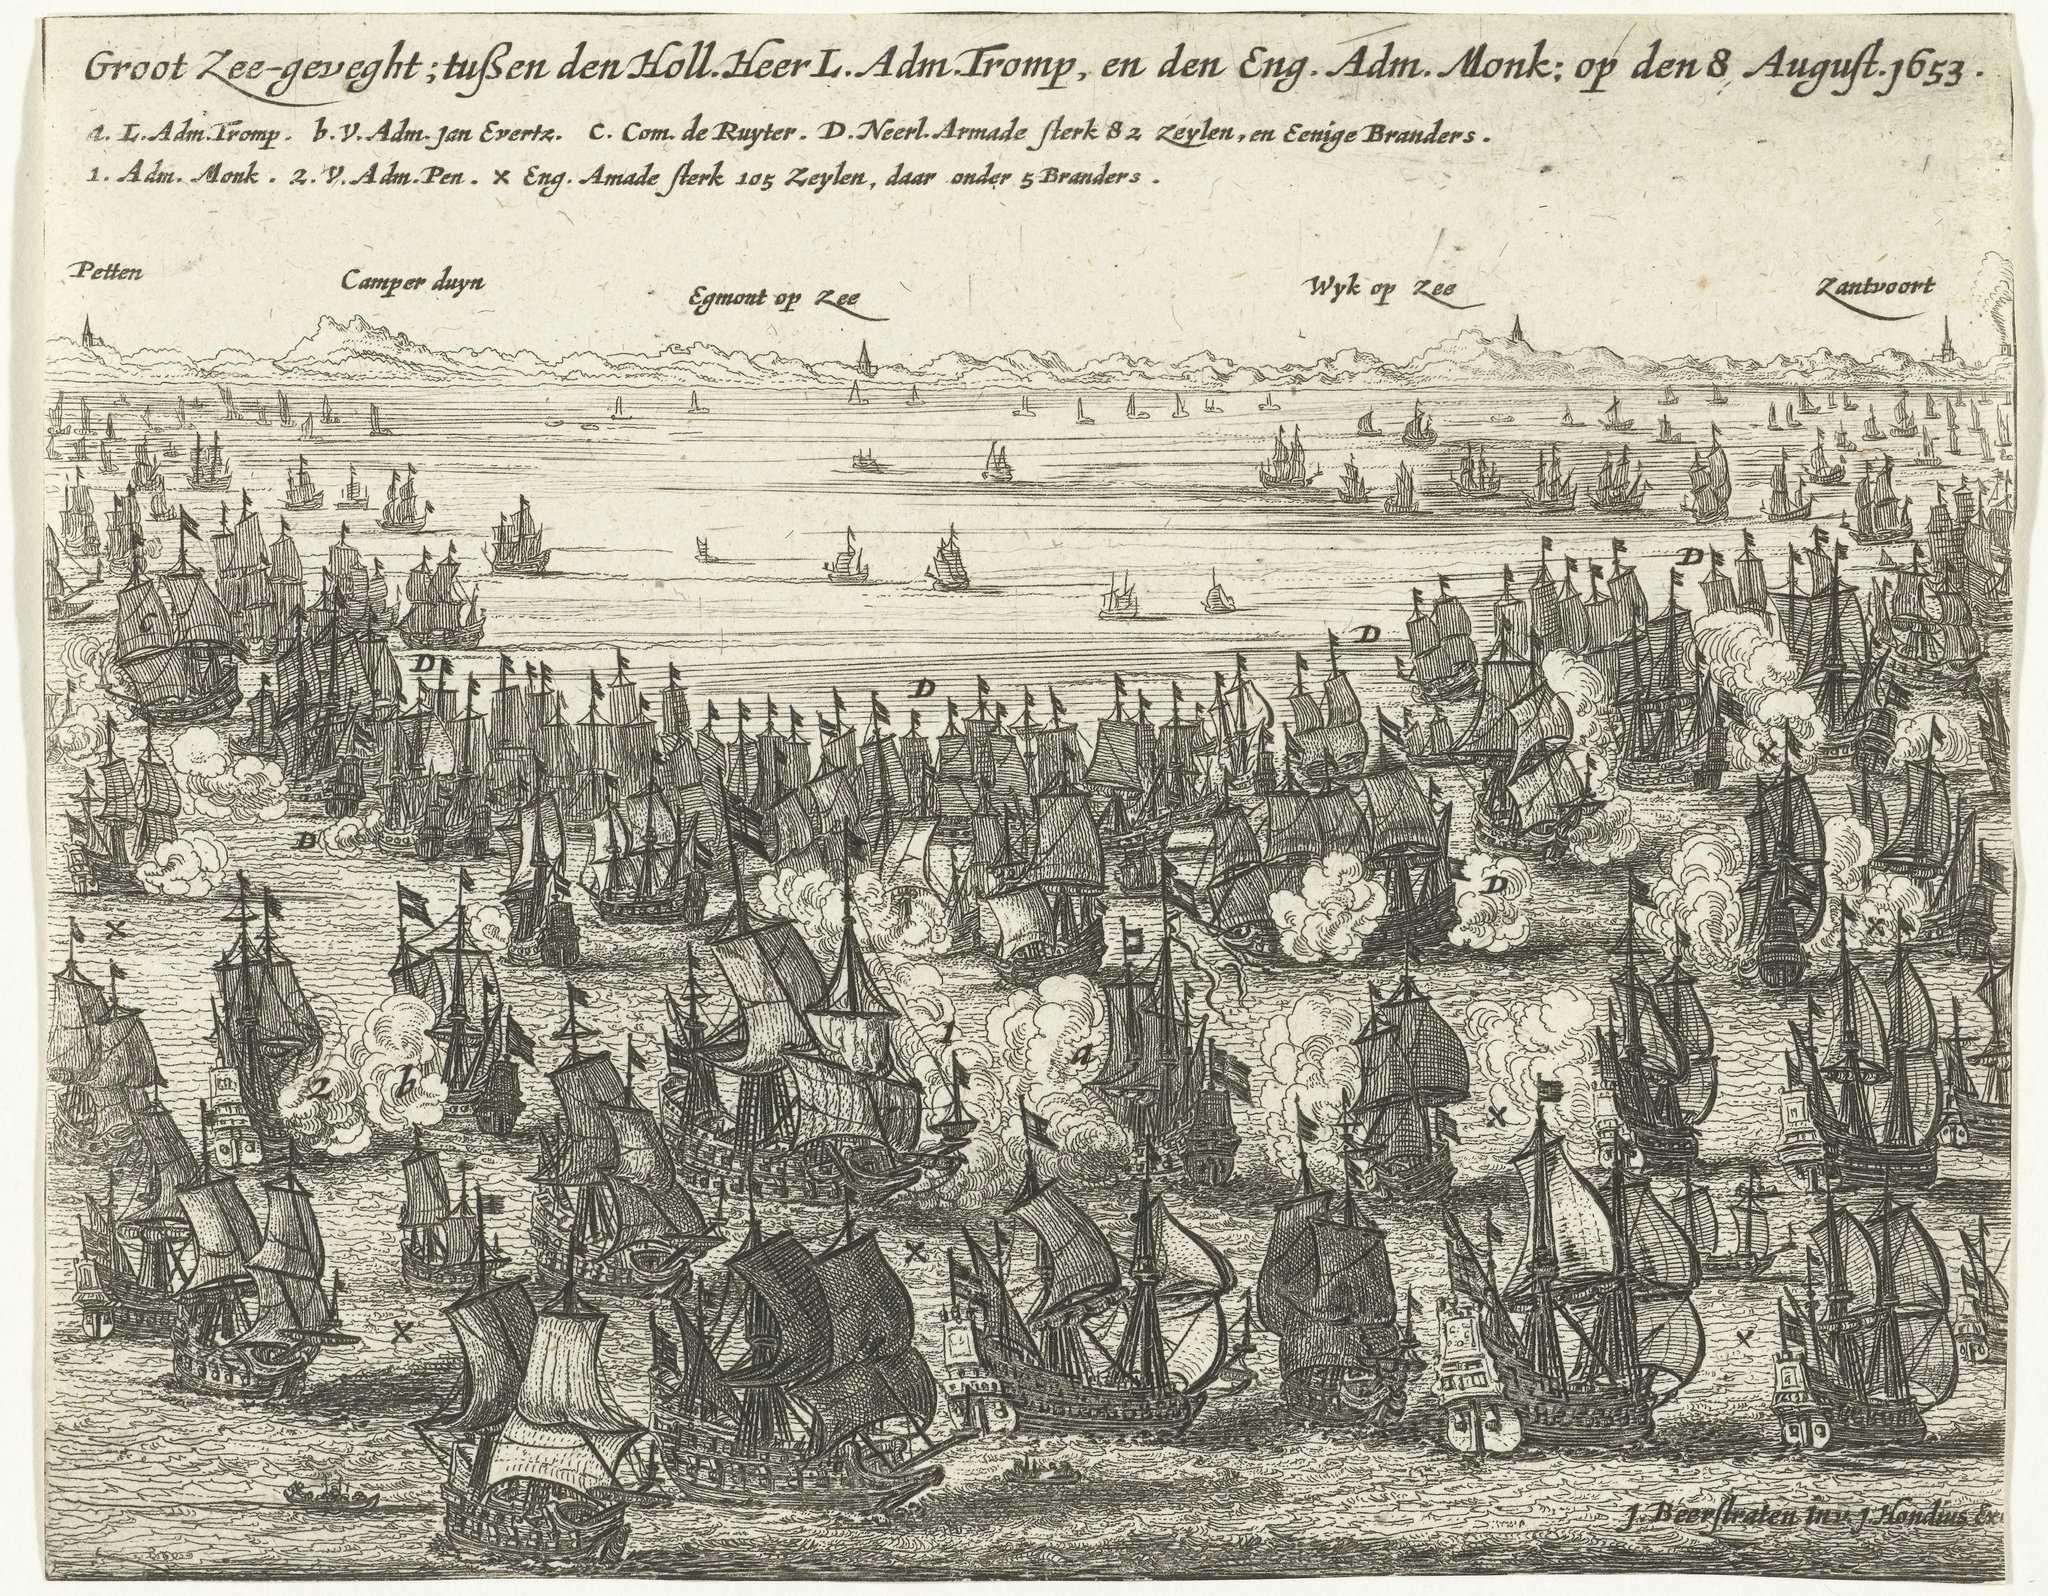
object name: print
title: Groot Zee-geveght; tussen den Holl. Heer L. Adm. Tromp, en den Eng. Adm. Monk: op den 8 August. 1653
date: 1654-1656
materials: paper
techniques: etching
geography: northern netherlands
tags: maarten harpertszoon tromp, battle (+ naval force)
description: Zeegevechten voor de Hollandse kust in de Eerste Engelse Oorlog tussen de Staatse vloot onder Maarten Tromp en de Engelse vloot onder George Monck, 8 augustus 1653. Bovenaan de legenda a-d en 1-2. Ongenummerd [13].